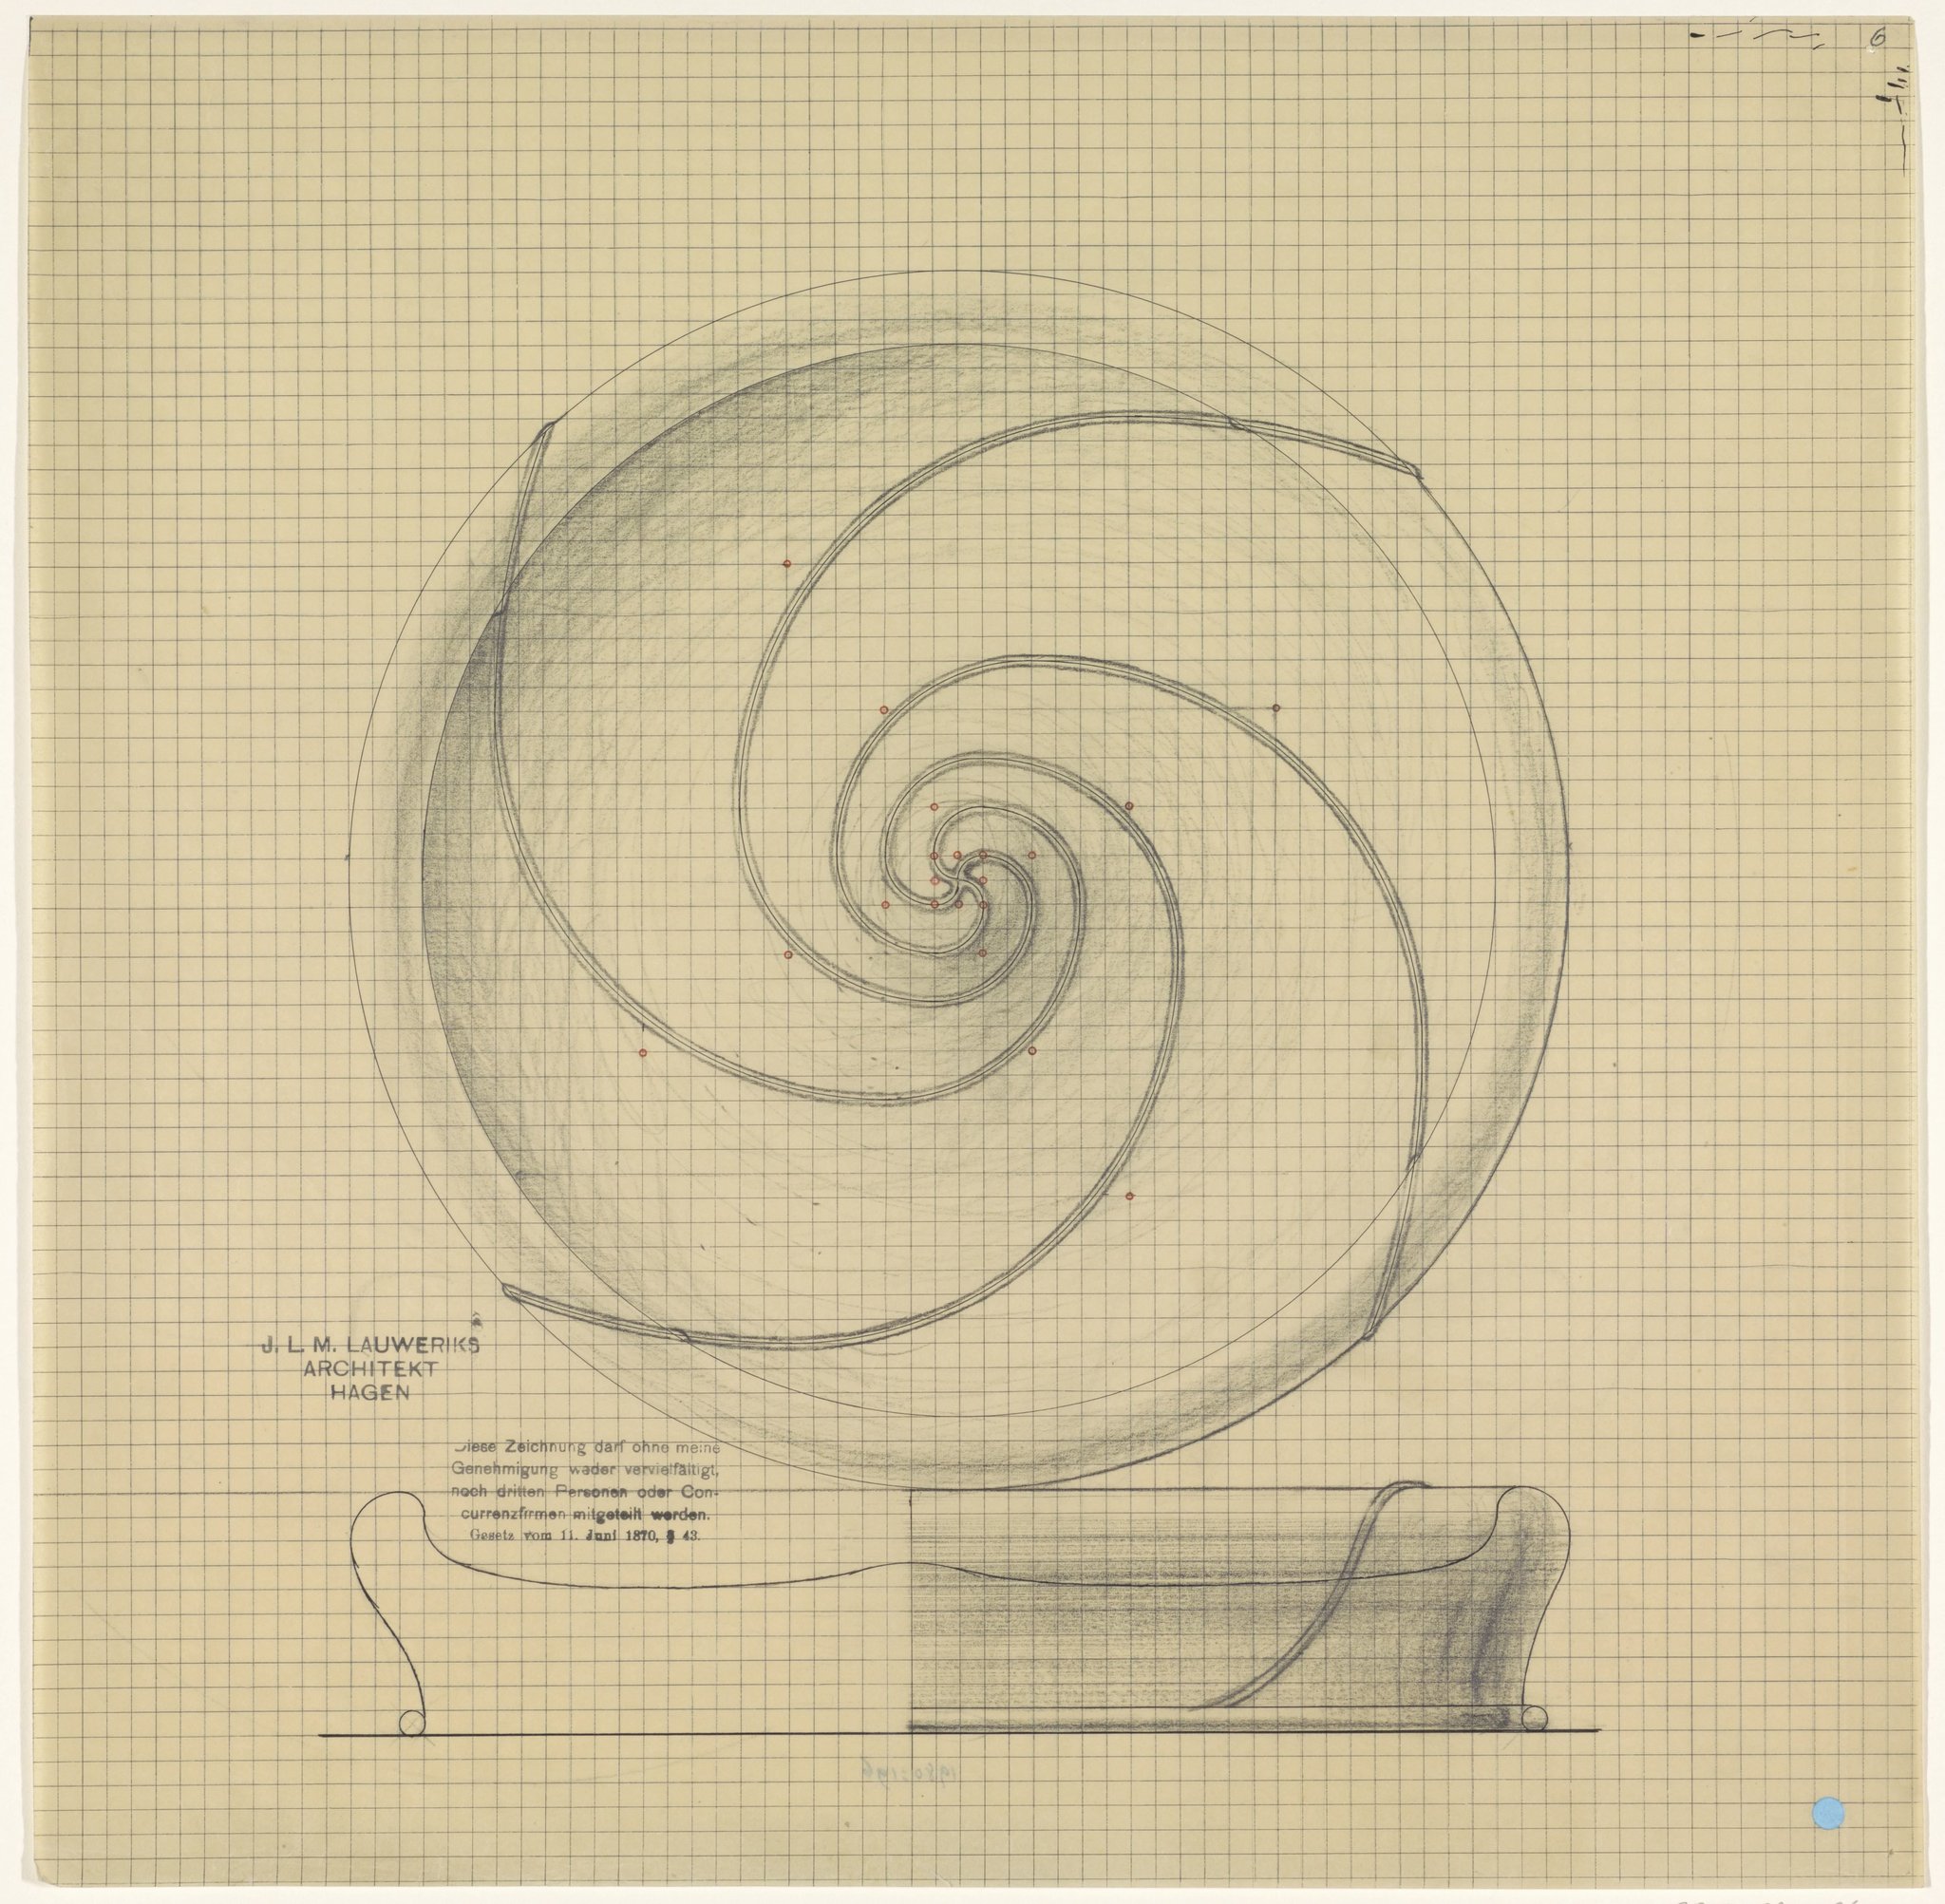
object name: design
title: Ontwerp voor een zilveren fruitschaal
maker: mathieu lauweriks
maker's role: designer, draughtsman, print maker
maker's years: 1864-1932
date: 1874-1932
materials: chalk, ink, pencil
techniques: pen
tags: dish, plate, saucer, work of applied art (+ precious metals ~ arts)